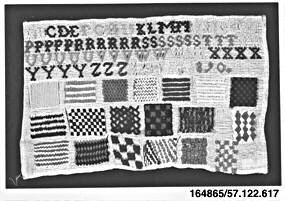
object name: sampler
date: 1801-1900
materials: canvas, wool